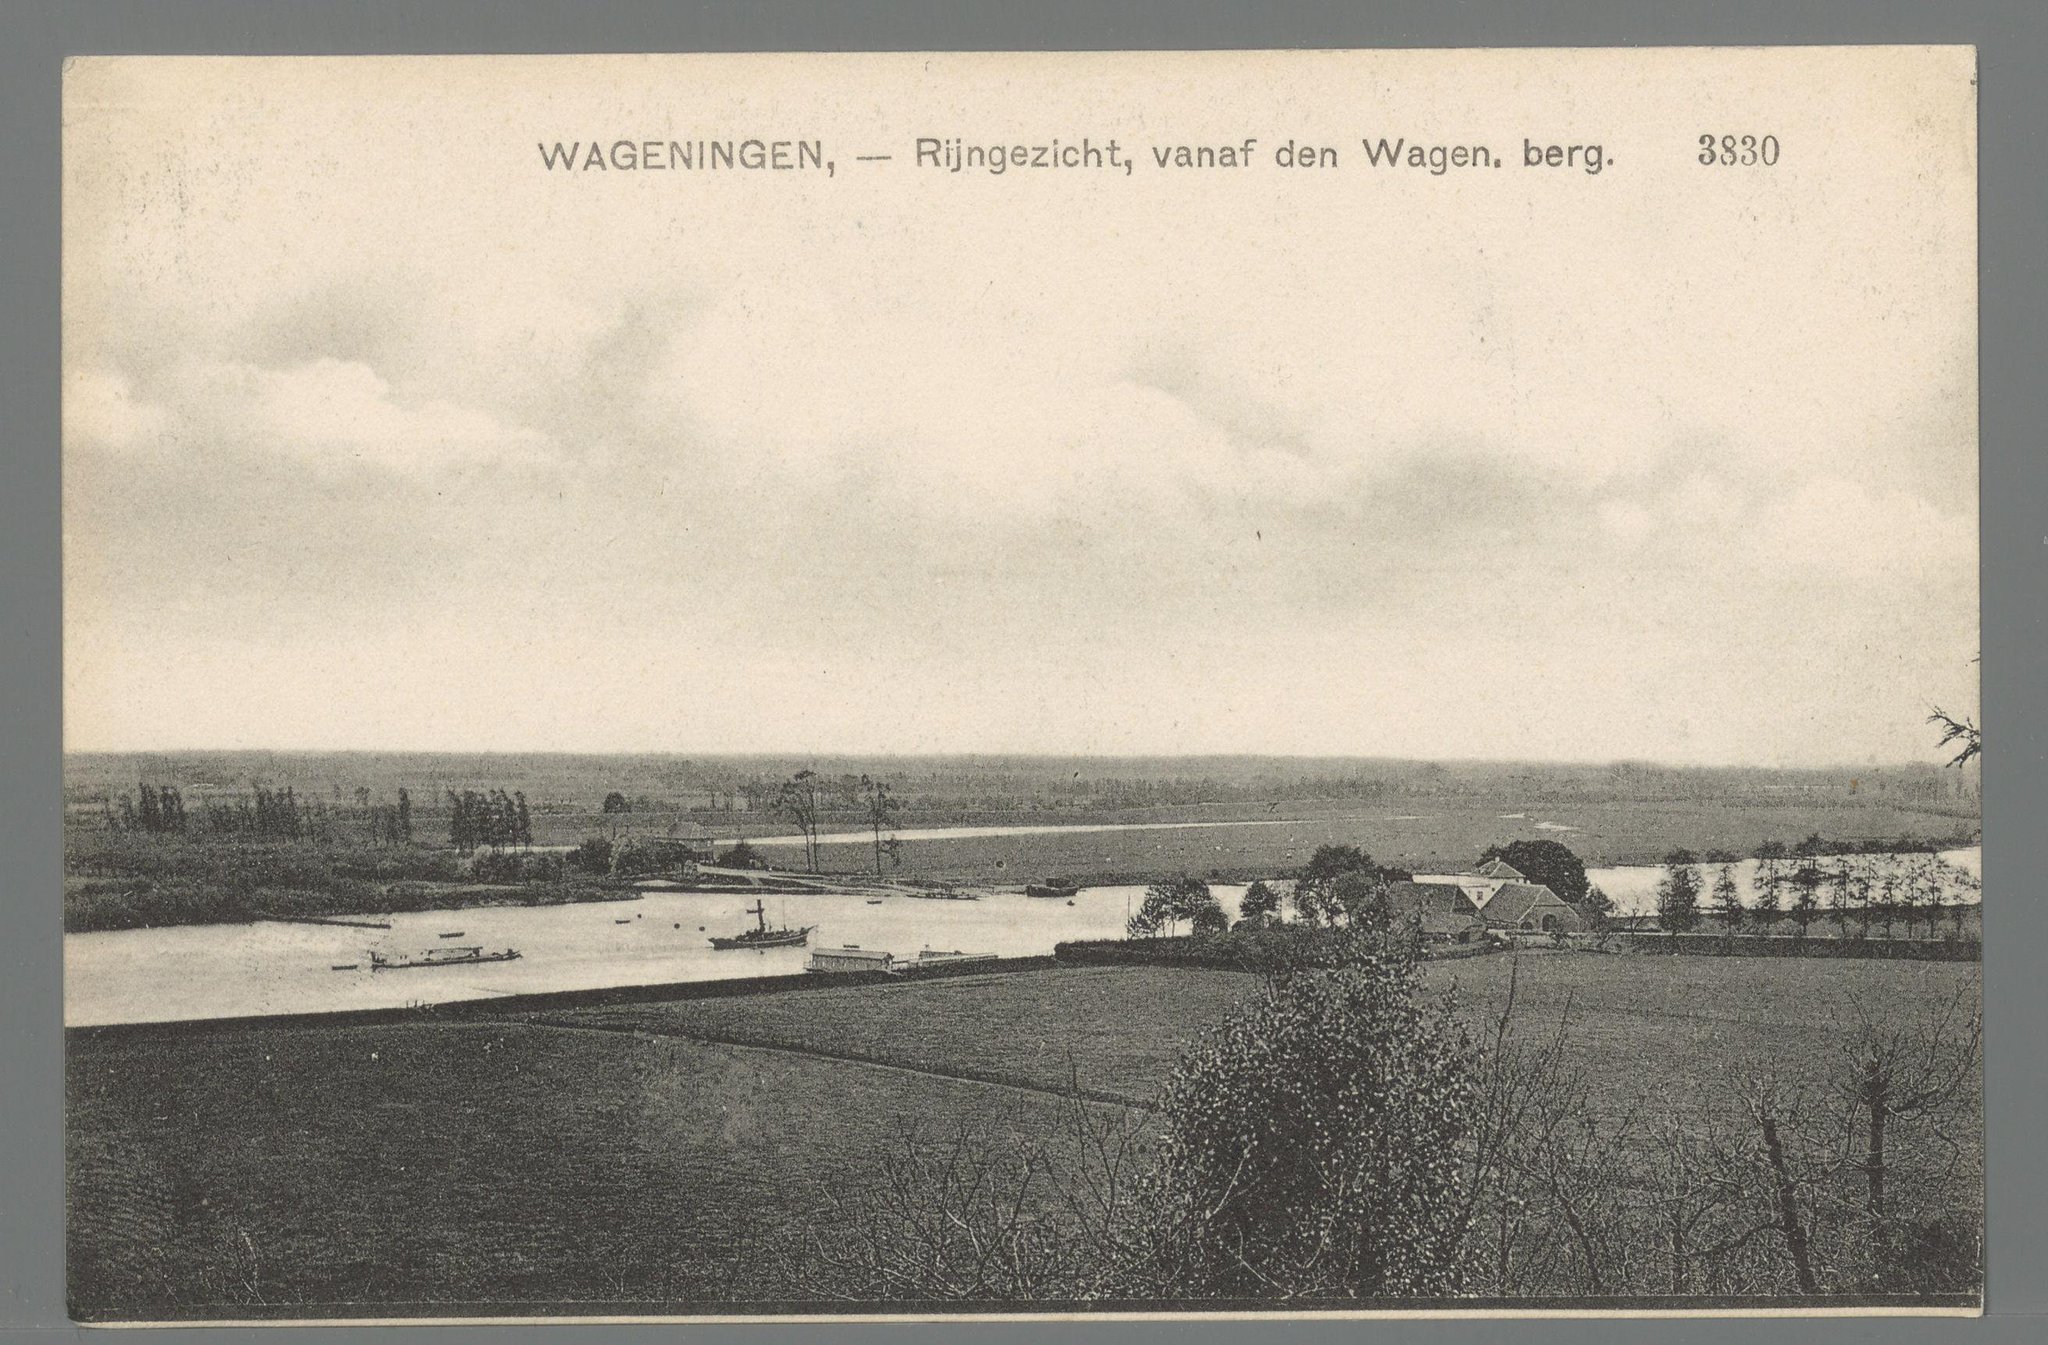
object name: photomechanical print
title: Wageningen, - Rijngezicht, vanaf den Wagen. berg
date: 1905-1927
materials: cardboard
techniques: photograph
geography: velsen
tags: river, lower rhine